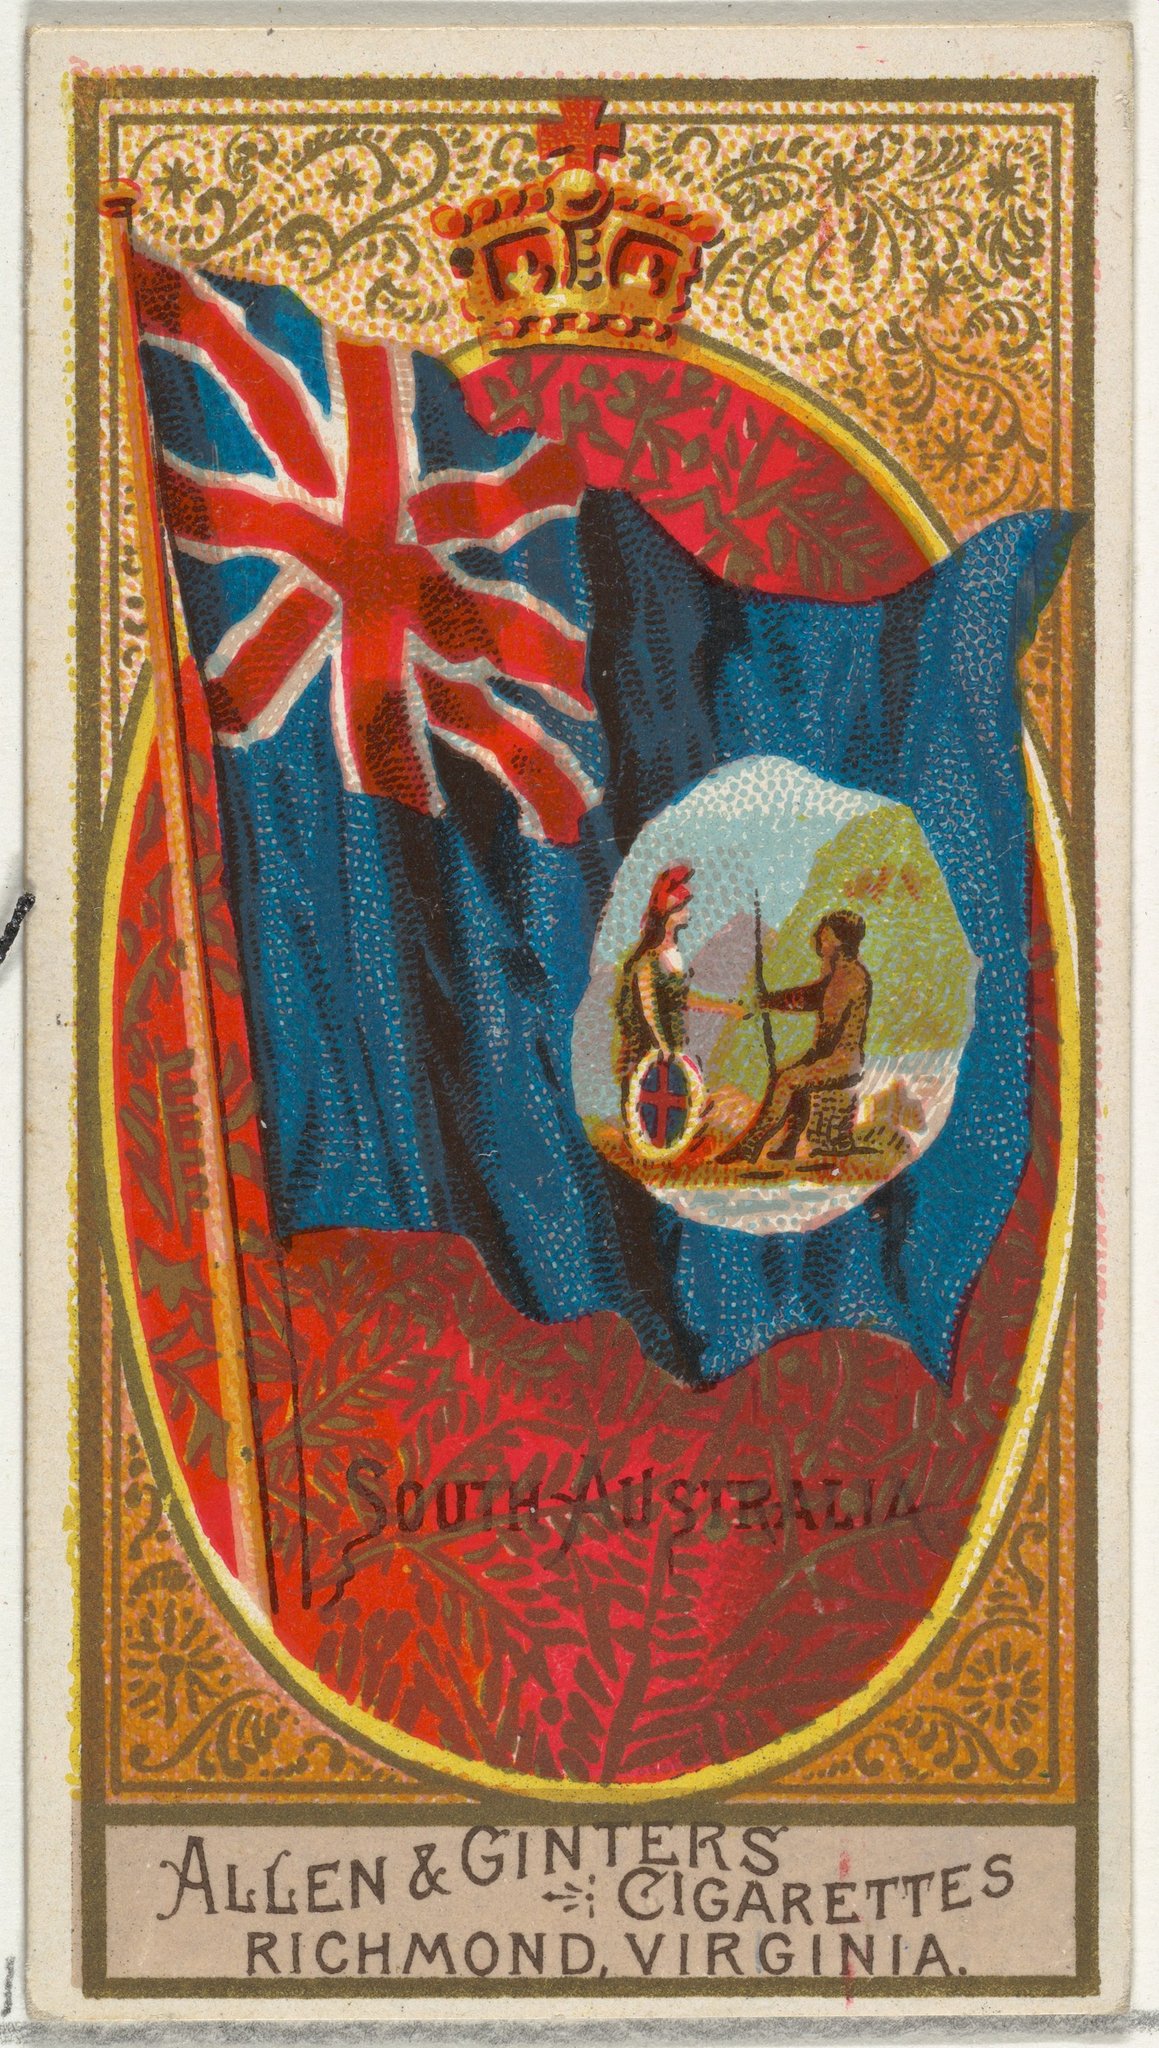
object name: print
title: South Australia, from Flags of All Nations, Series 2 (N10) for Allen & Ginter Cigarettes Brands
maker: allen & ginter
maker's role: publisher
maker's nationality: american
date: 1890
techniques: color lithograph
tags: flags